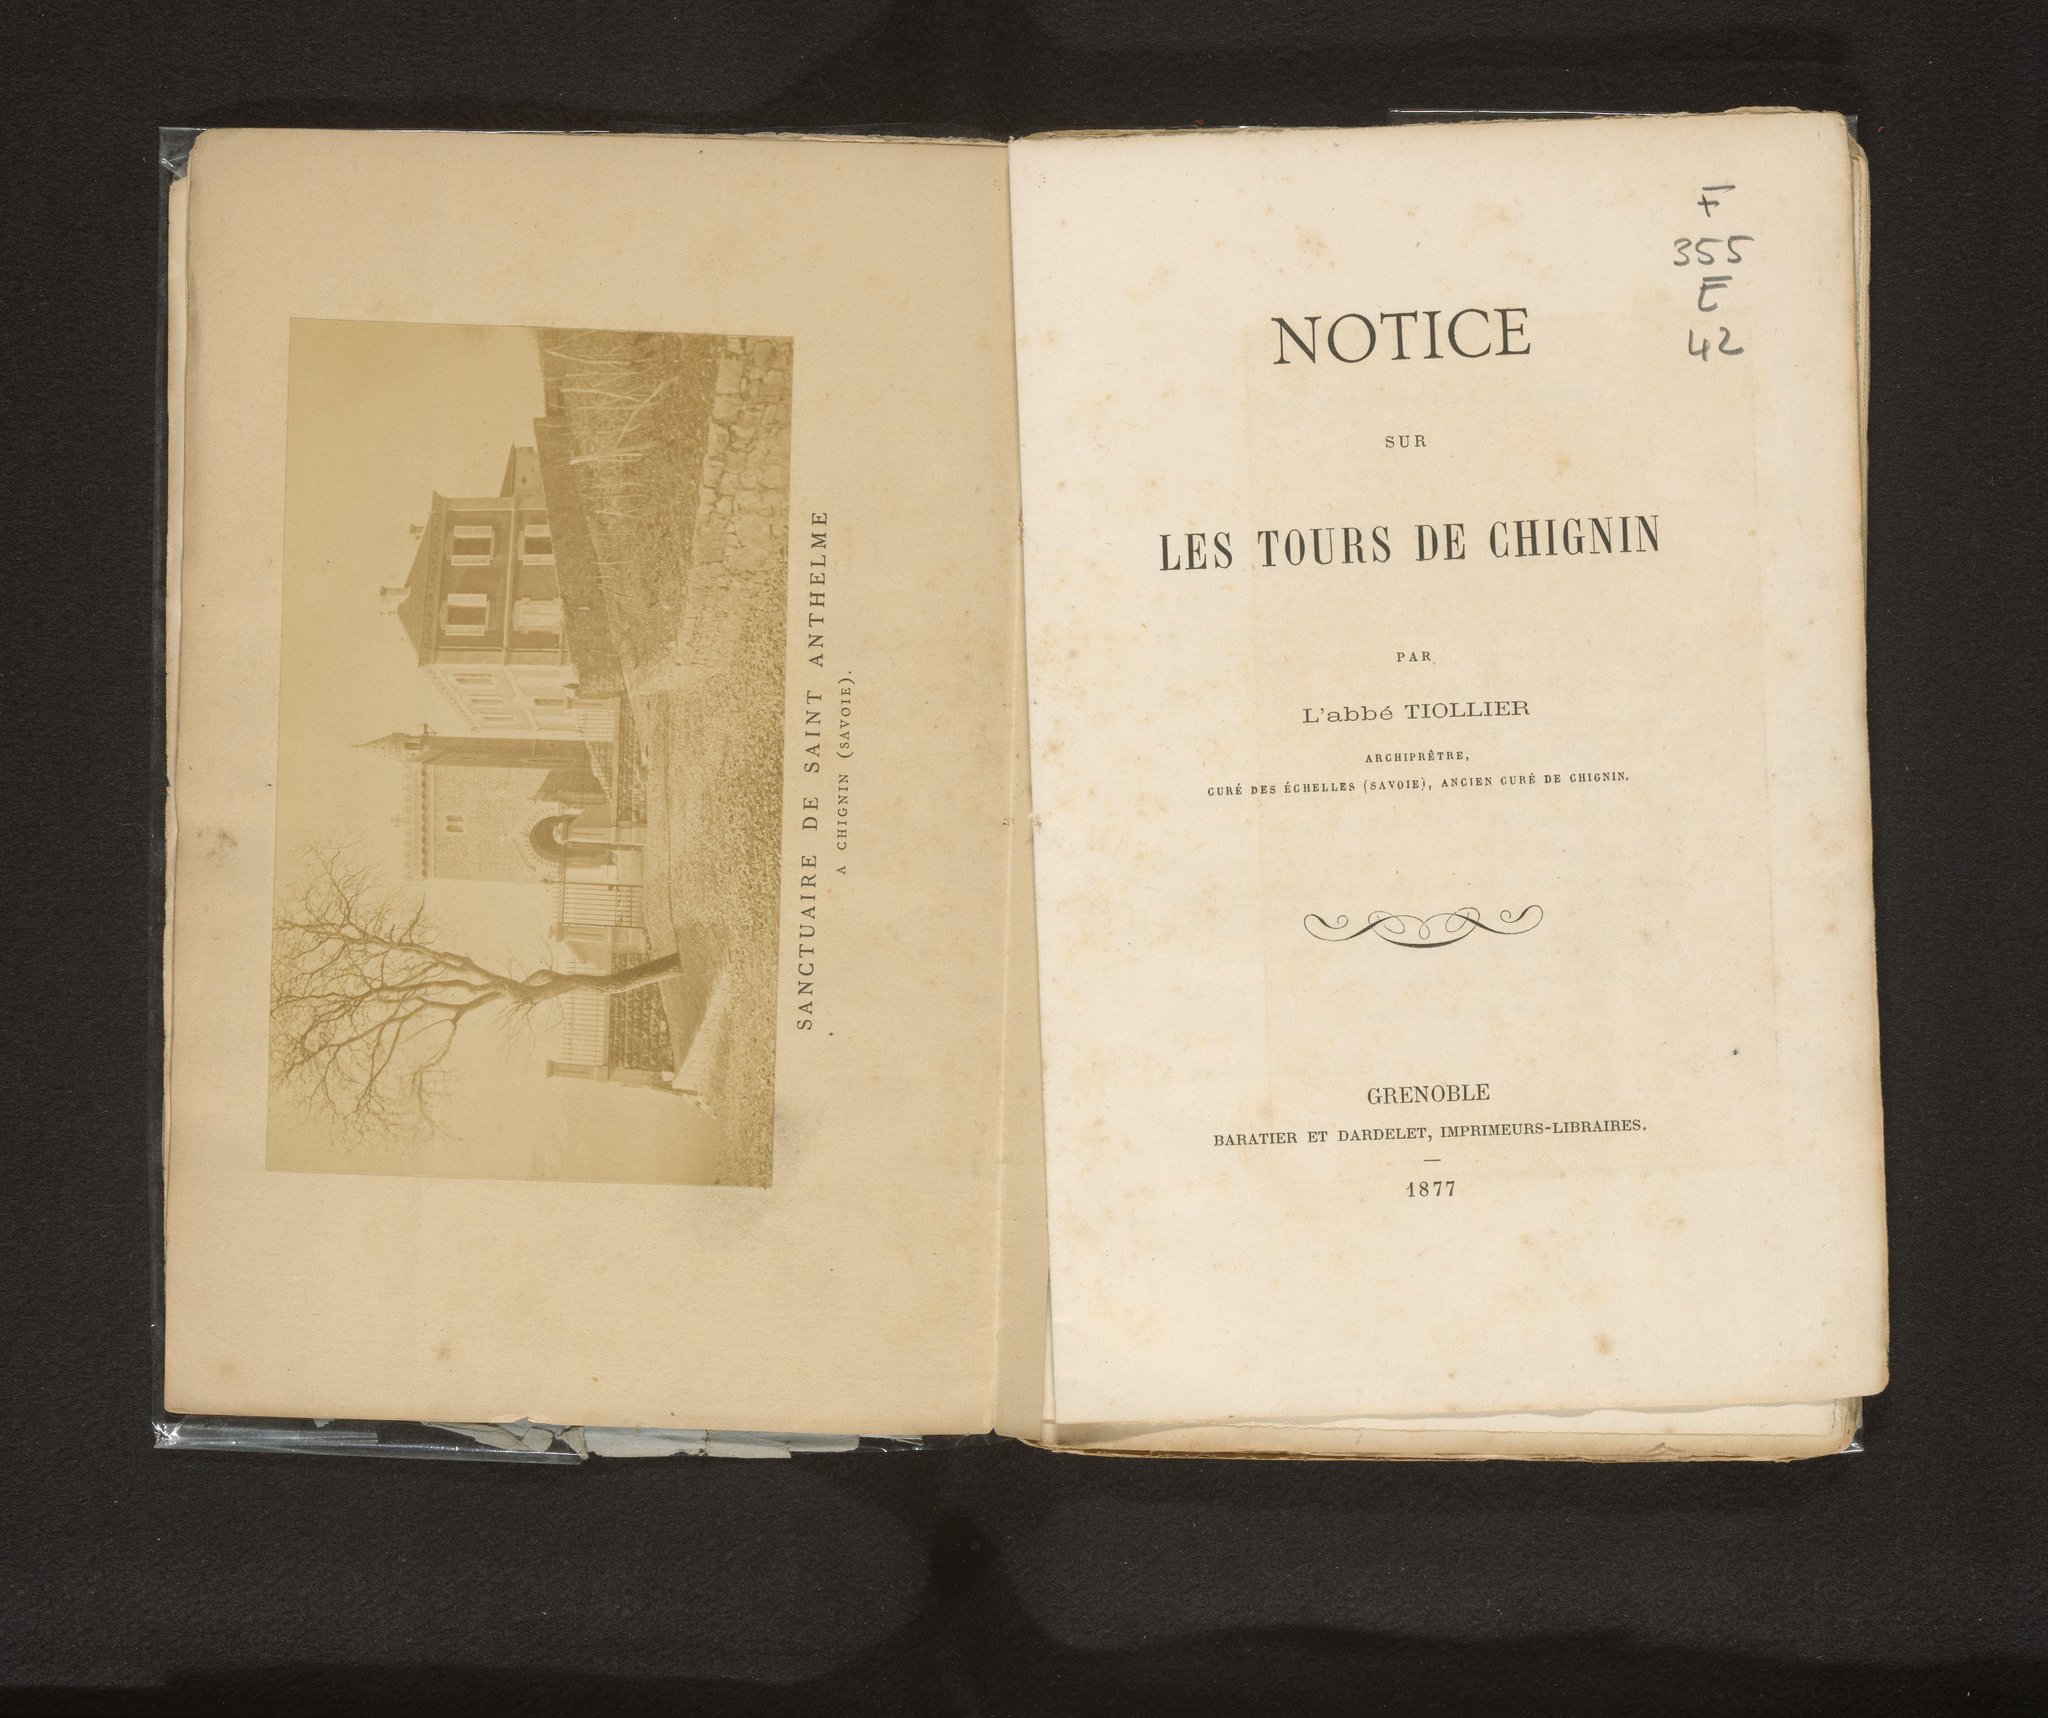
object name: page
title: Sanctuaire de Saint Anthelme a Chignin (Savoie)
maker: Anonymous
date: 1867-1877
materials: photographic support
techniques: albumen print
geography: chignin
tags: tower, clock tower ~ monumental adornment